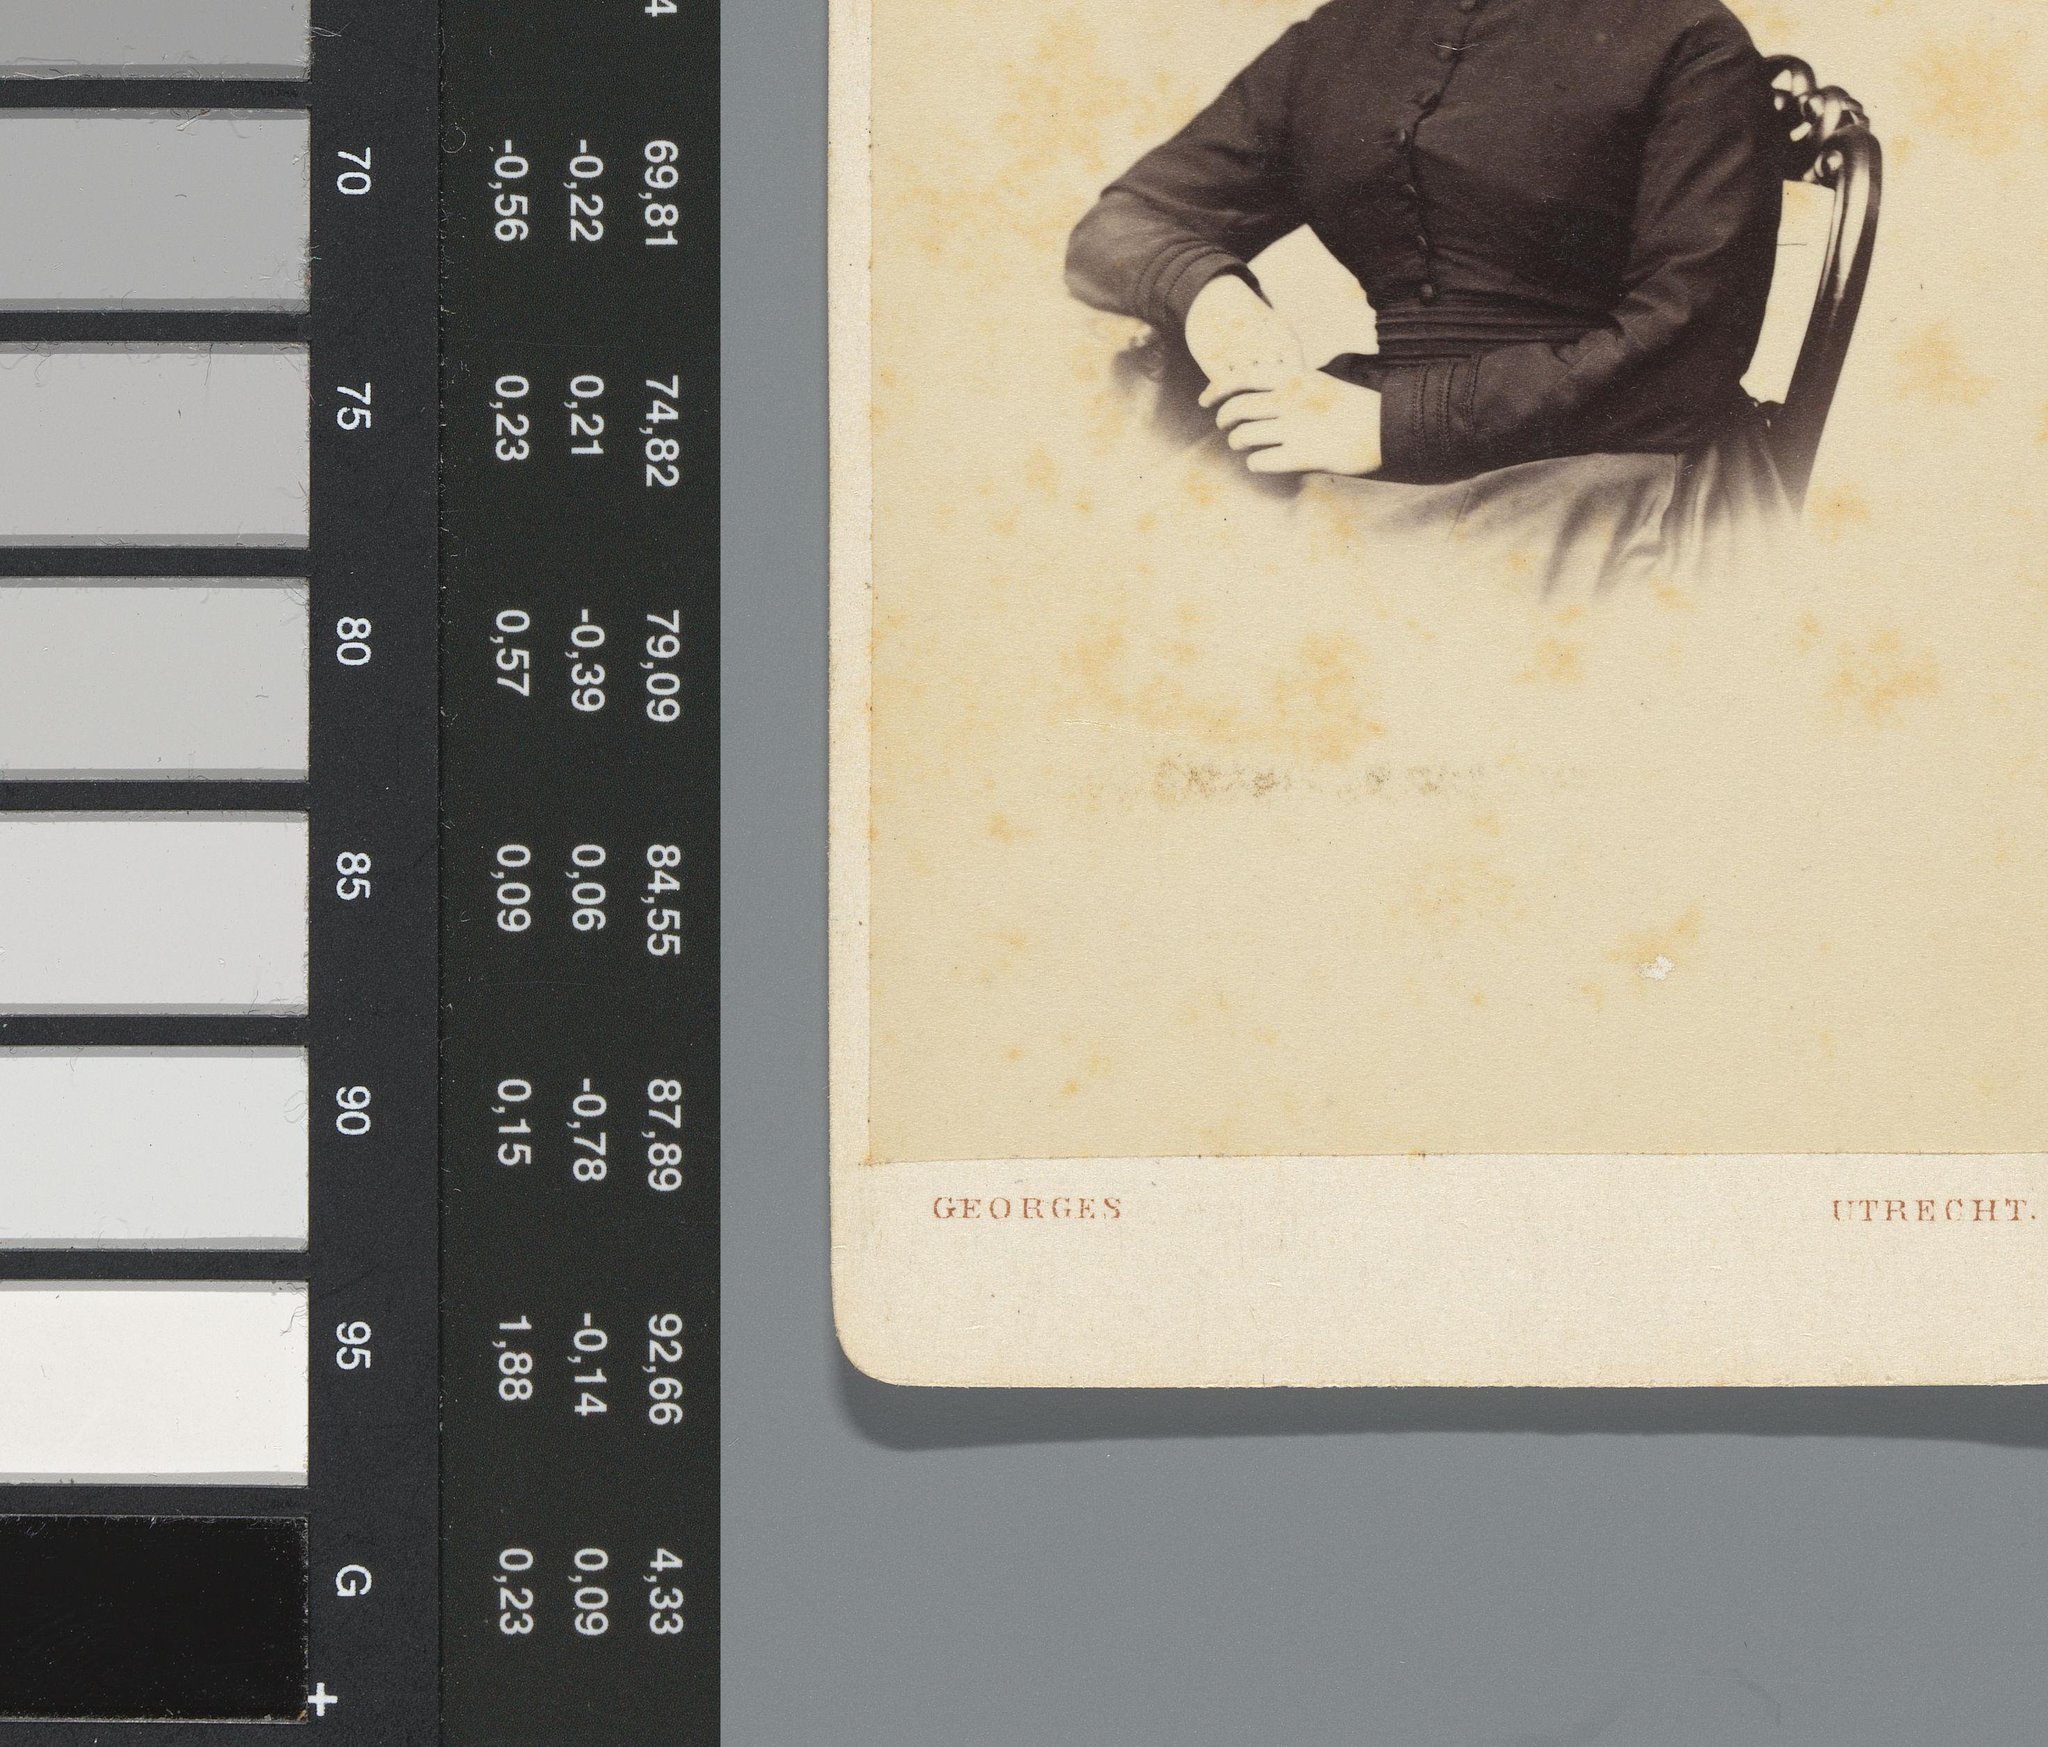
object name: carte de visite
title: Portret van Joanna Emilia Agnes van den Berg (Jeanette)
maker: eduard françois georges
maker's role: sculptor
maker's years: 1817-1895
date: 1855-1910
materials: cardboard, photographic support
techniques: albumen print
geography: utrecht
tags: joanna emilia agnes van den berg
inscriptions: inscription: ‘J.E.A. Trip- / van den Berg’, name: ‘GEORGES UTRECHT.’, name: ‘Georges. / Statuaire / Photographe / UTRECHT / Vrouw Jutte straat / 344’